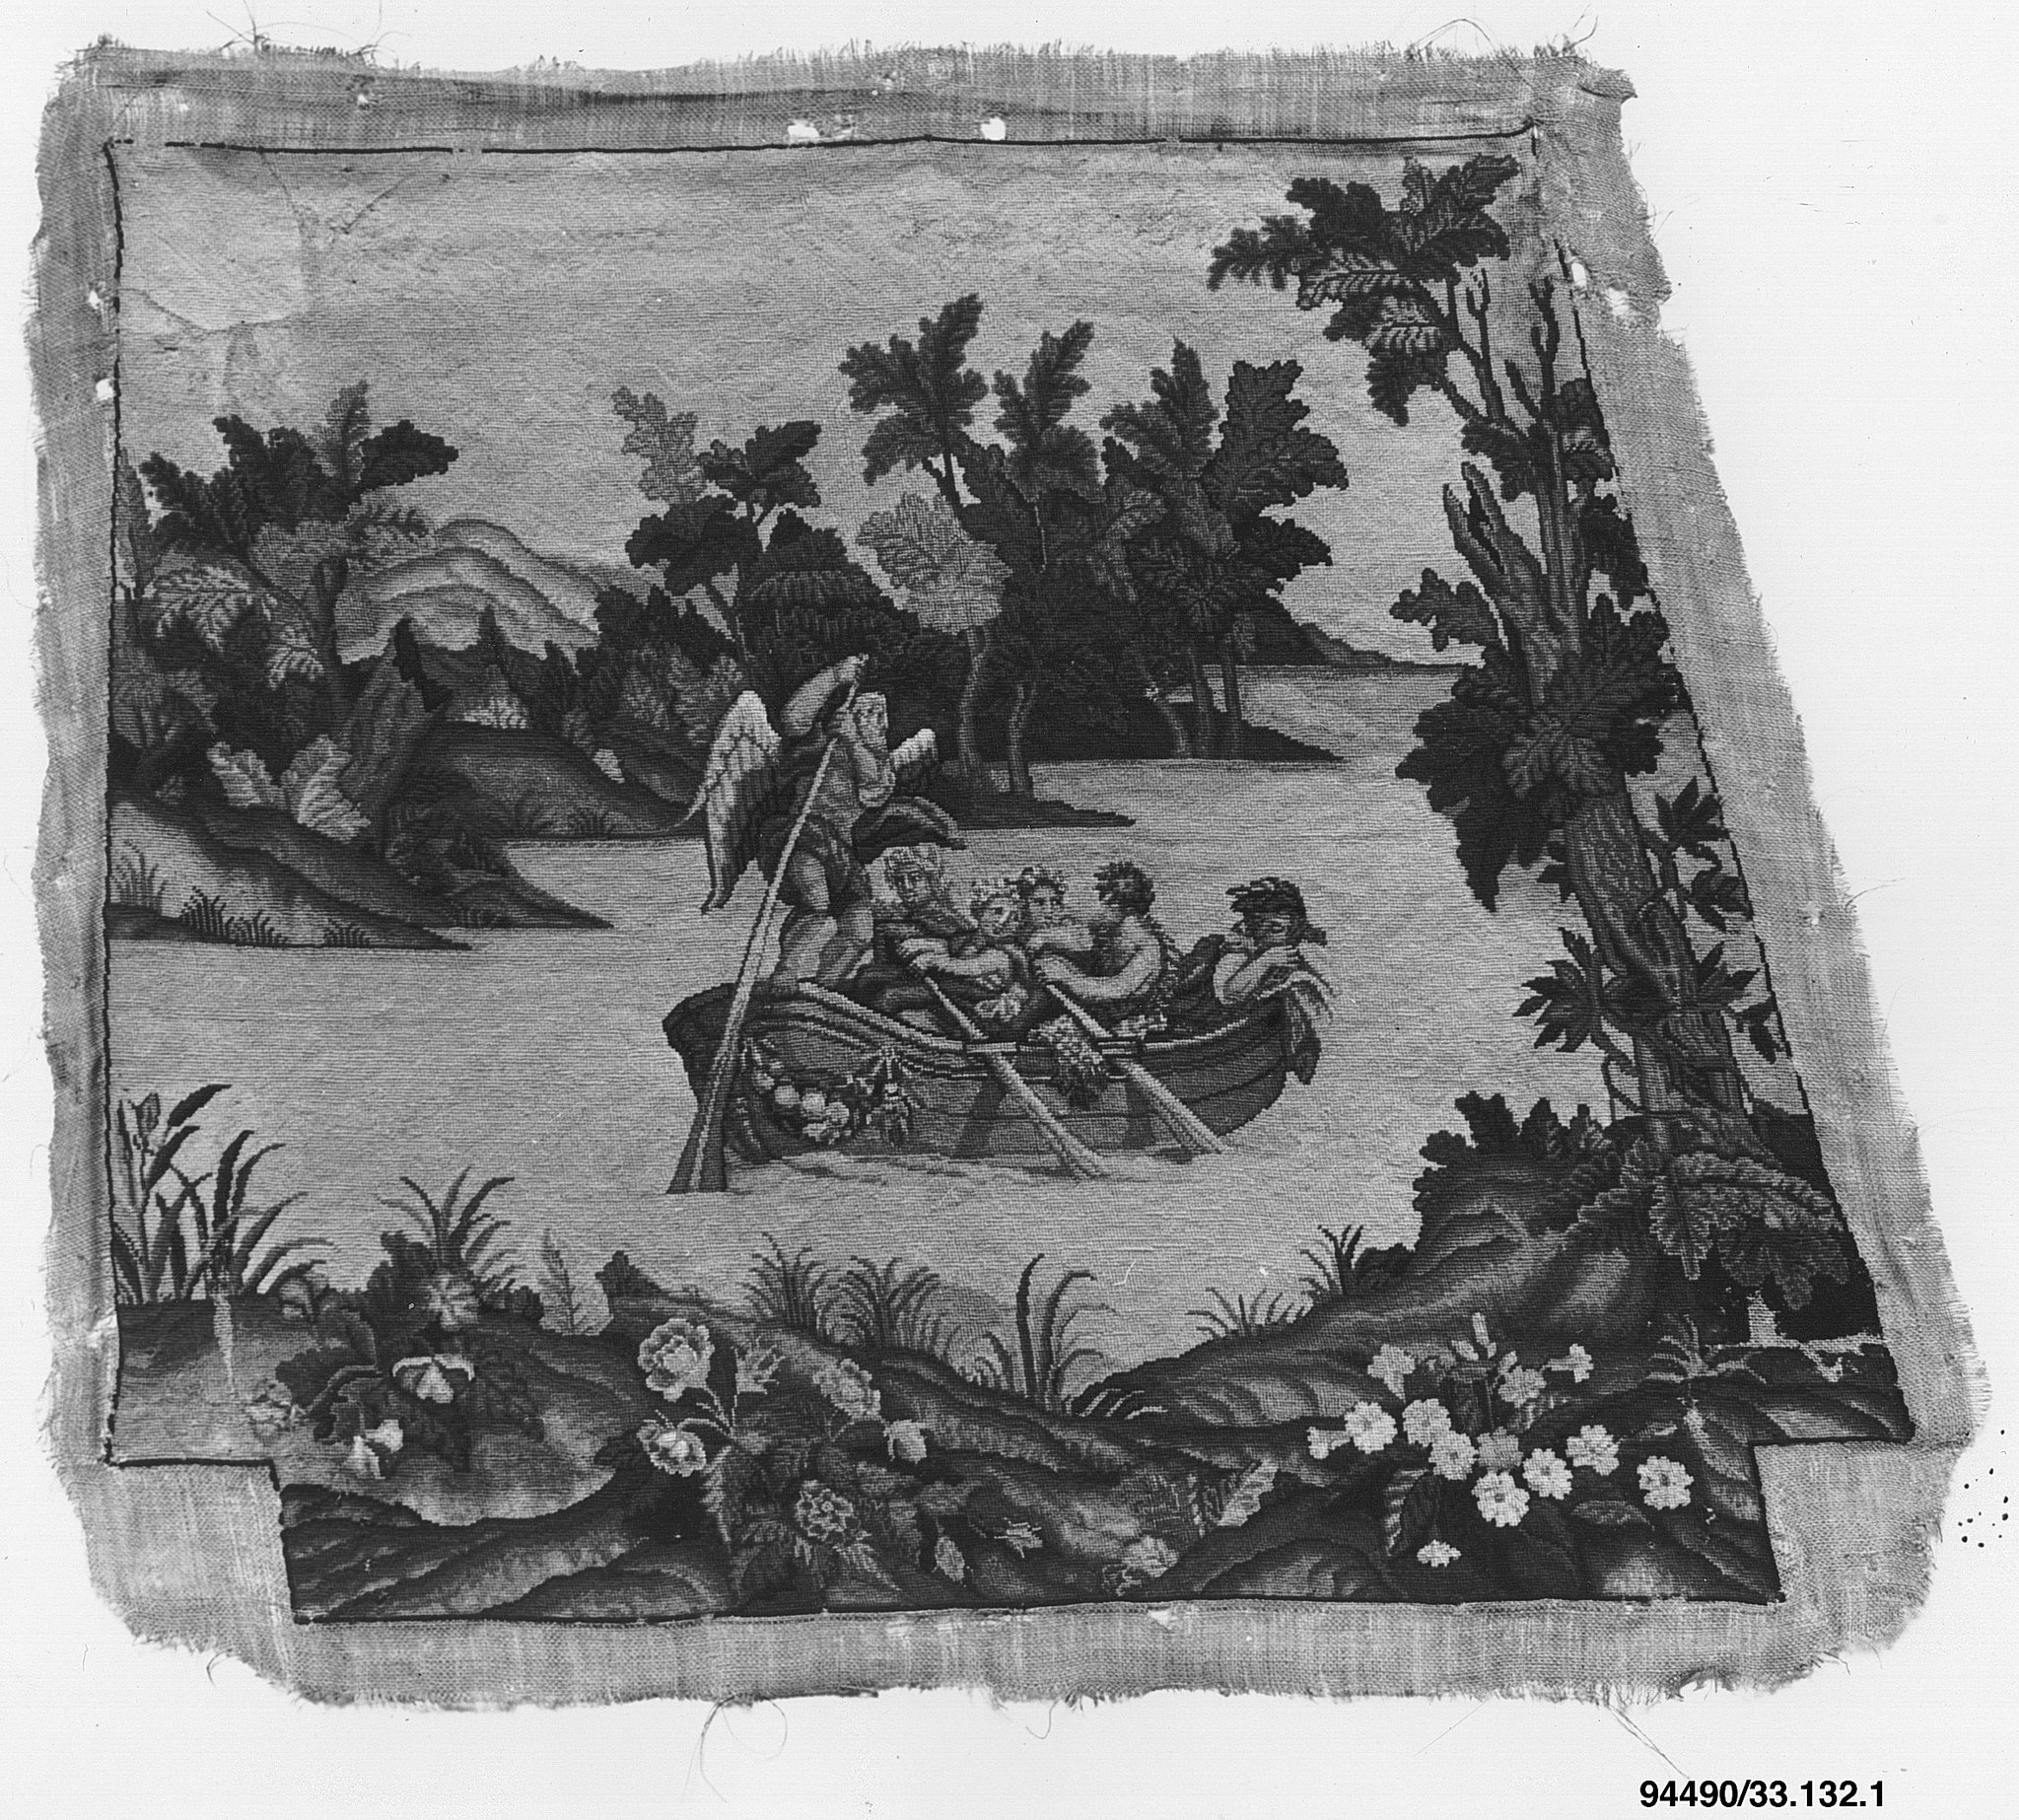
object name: cover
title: Chair seat cover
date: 1701-1800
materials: silk, wool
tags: men,trees,boats